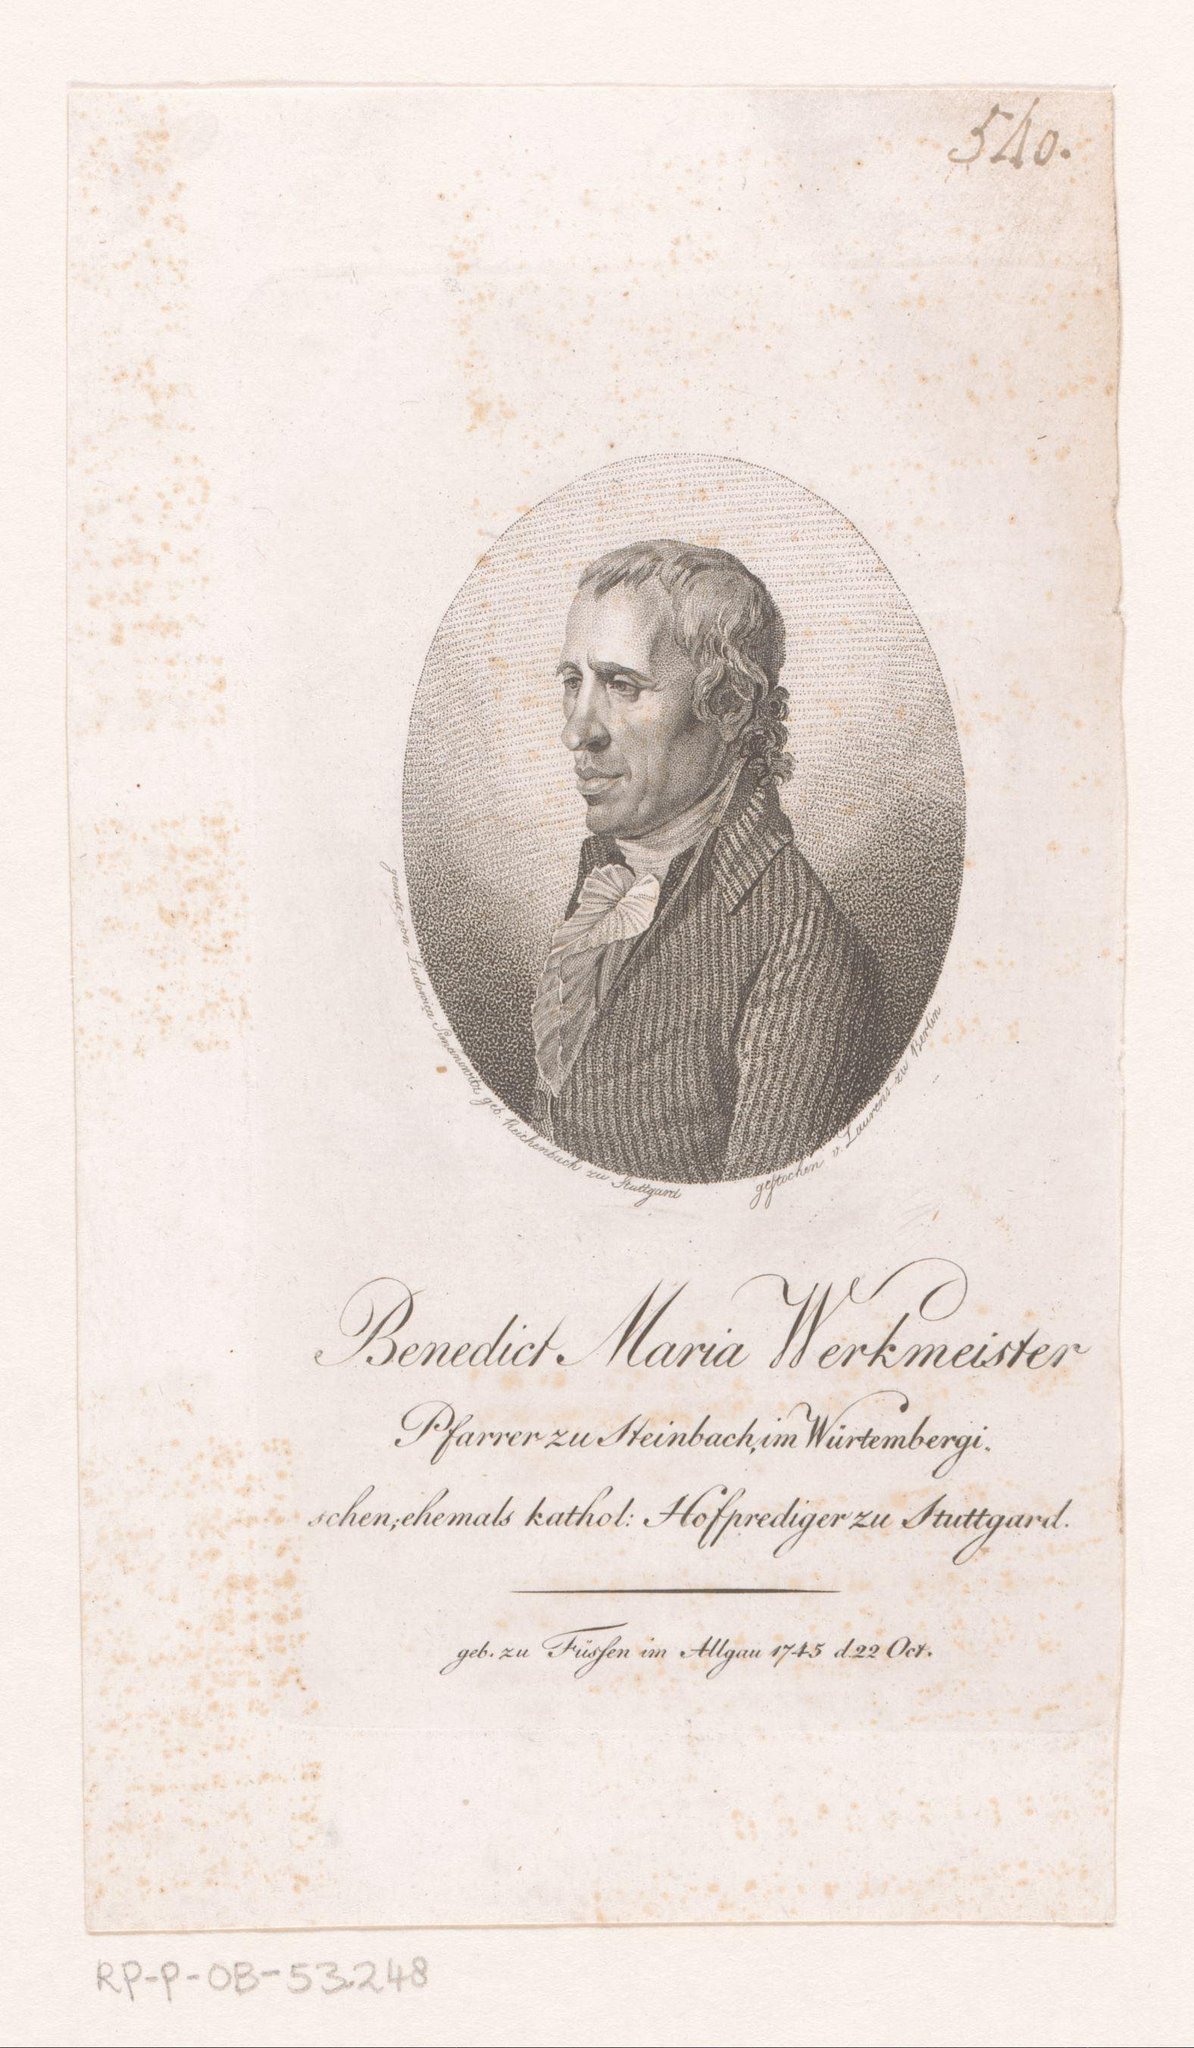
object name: print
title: Portret van Benedict Maria Werkmeister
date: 1780-1832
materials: paper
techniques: stippling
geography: berlin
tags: theologian, historical persons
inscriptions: collector's mark: Lugt 2228